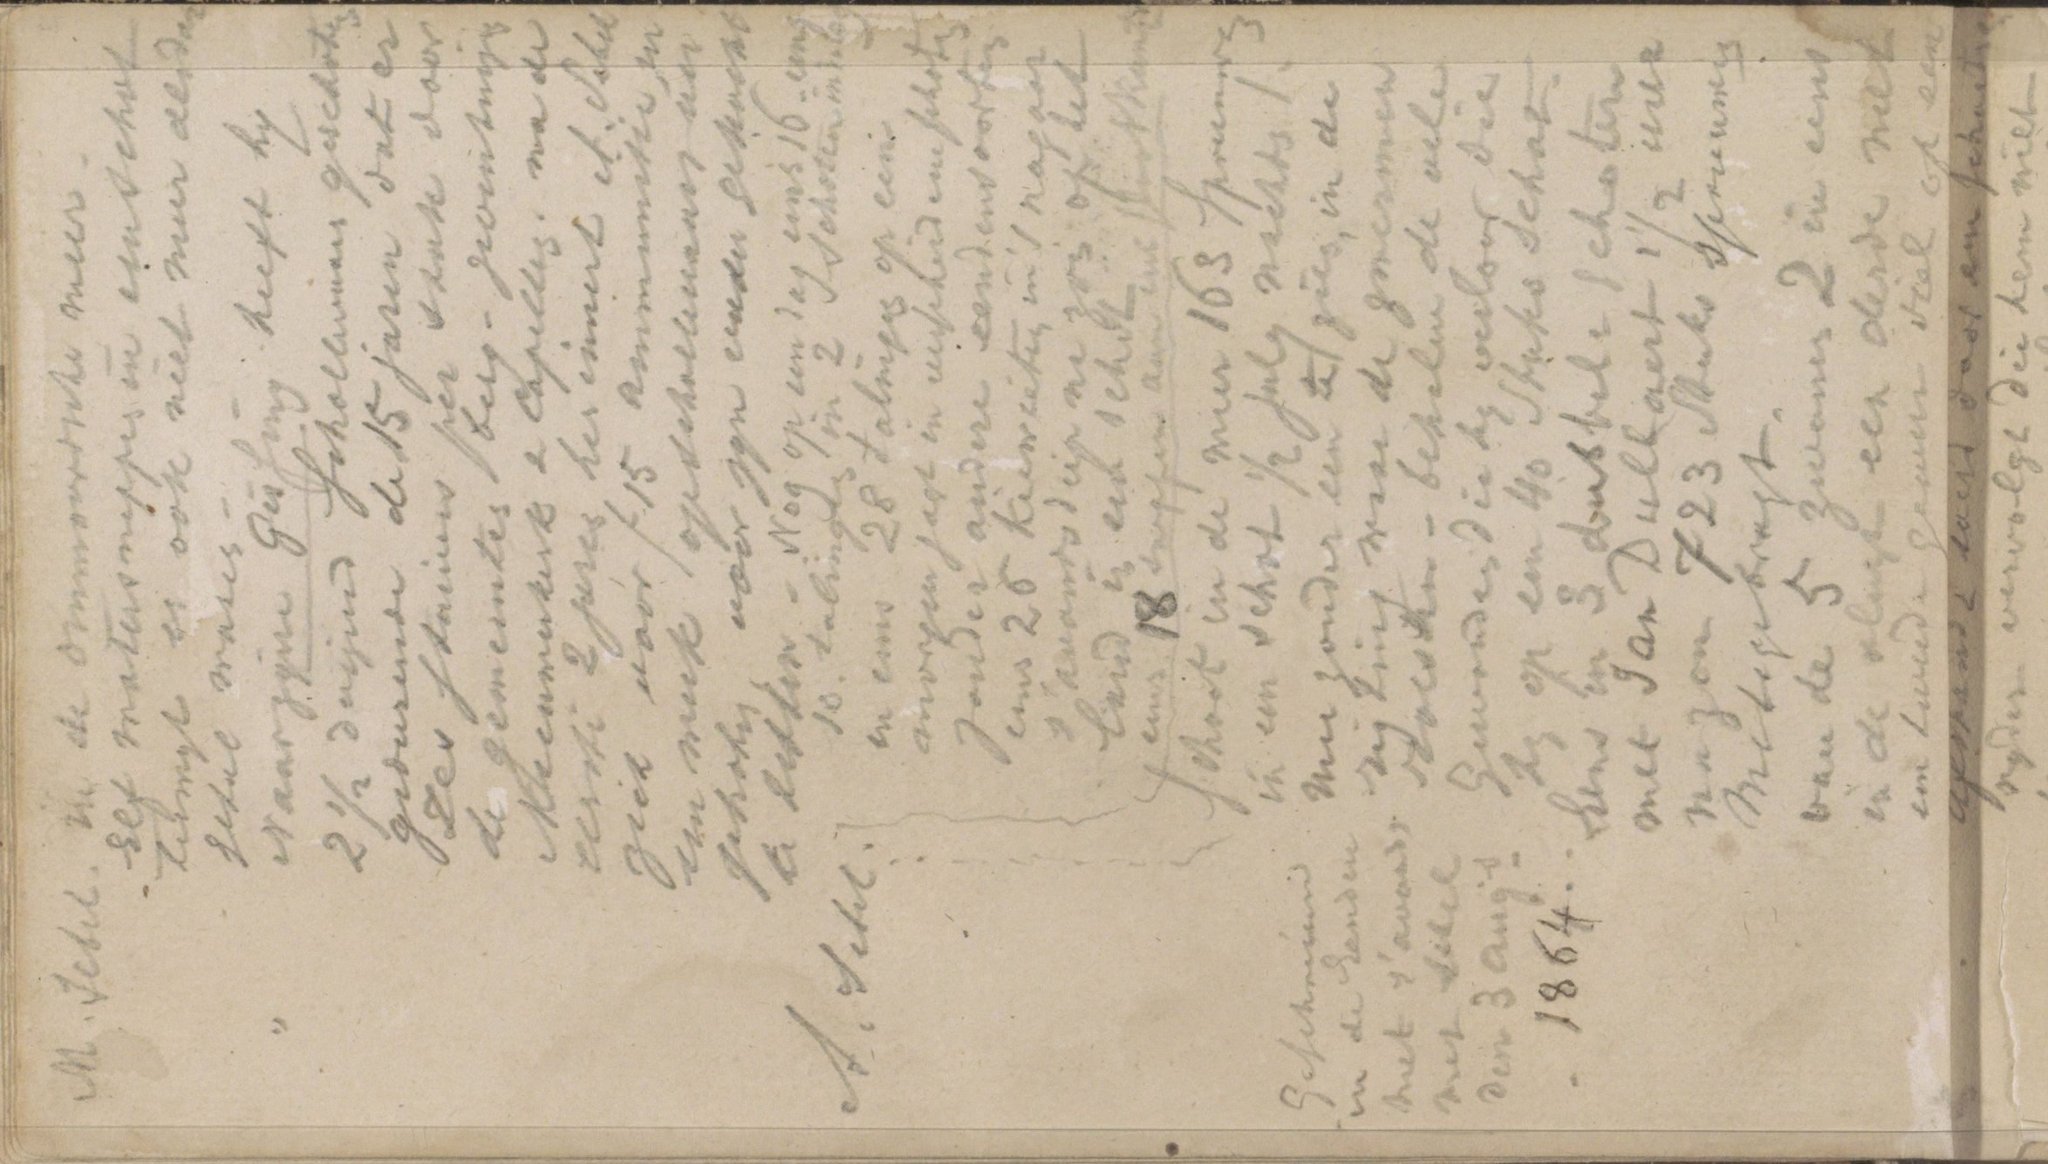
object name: sketchbook leaf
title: Notities over jachtopziener Ad Sebel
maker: johannes tavenraat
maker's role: draughtsman, painter, print maker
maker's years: 1809-1881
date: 1864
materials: paper, pencil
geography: capelle aan den ijssel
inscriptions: date and inscription: ‘[...]’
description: Sebel was jachtopziener van het jachthuis Sneppenschrik bij Capelle aan den IJssel.